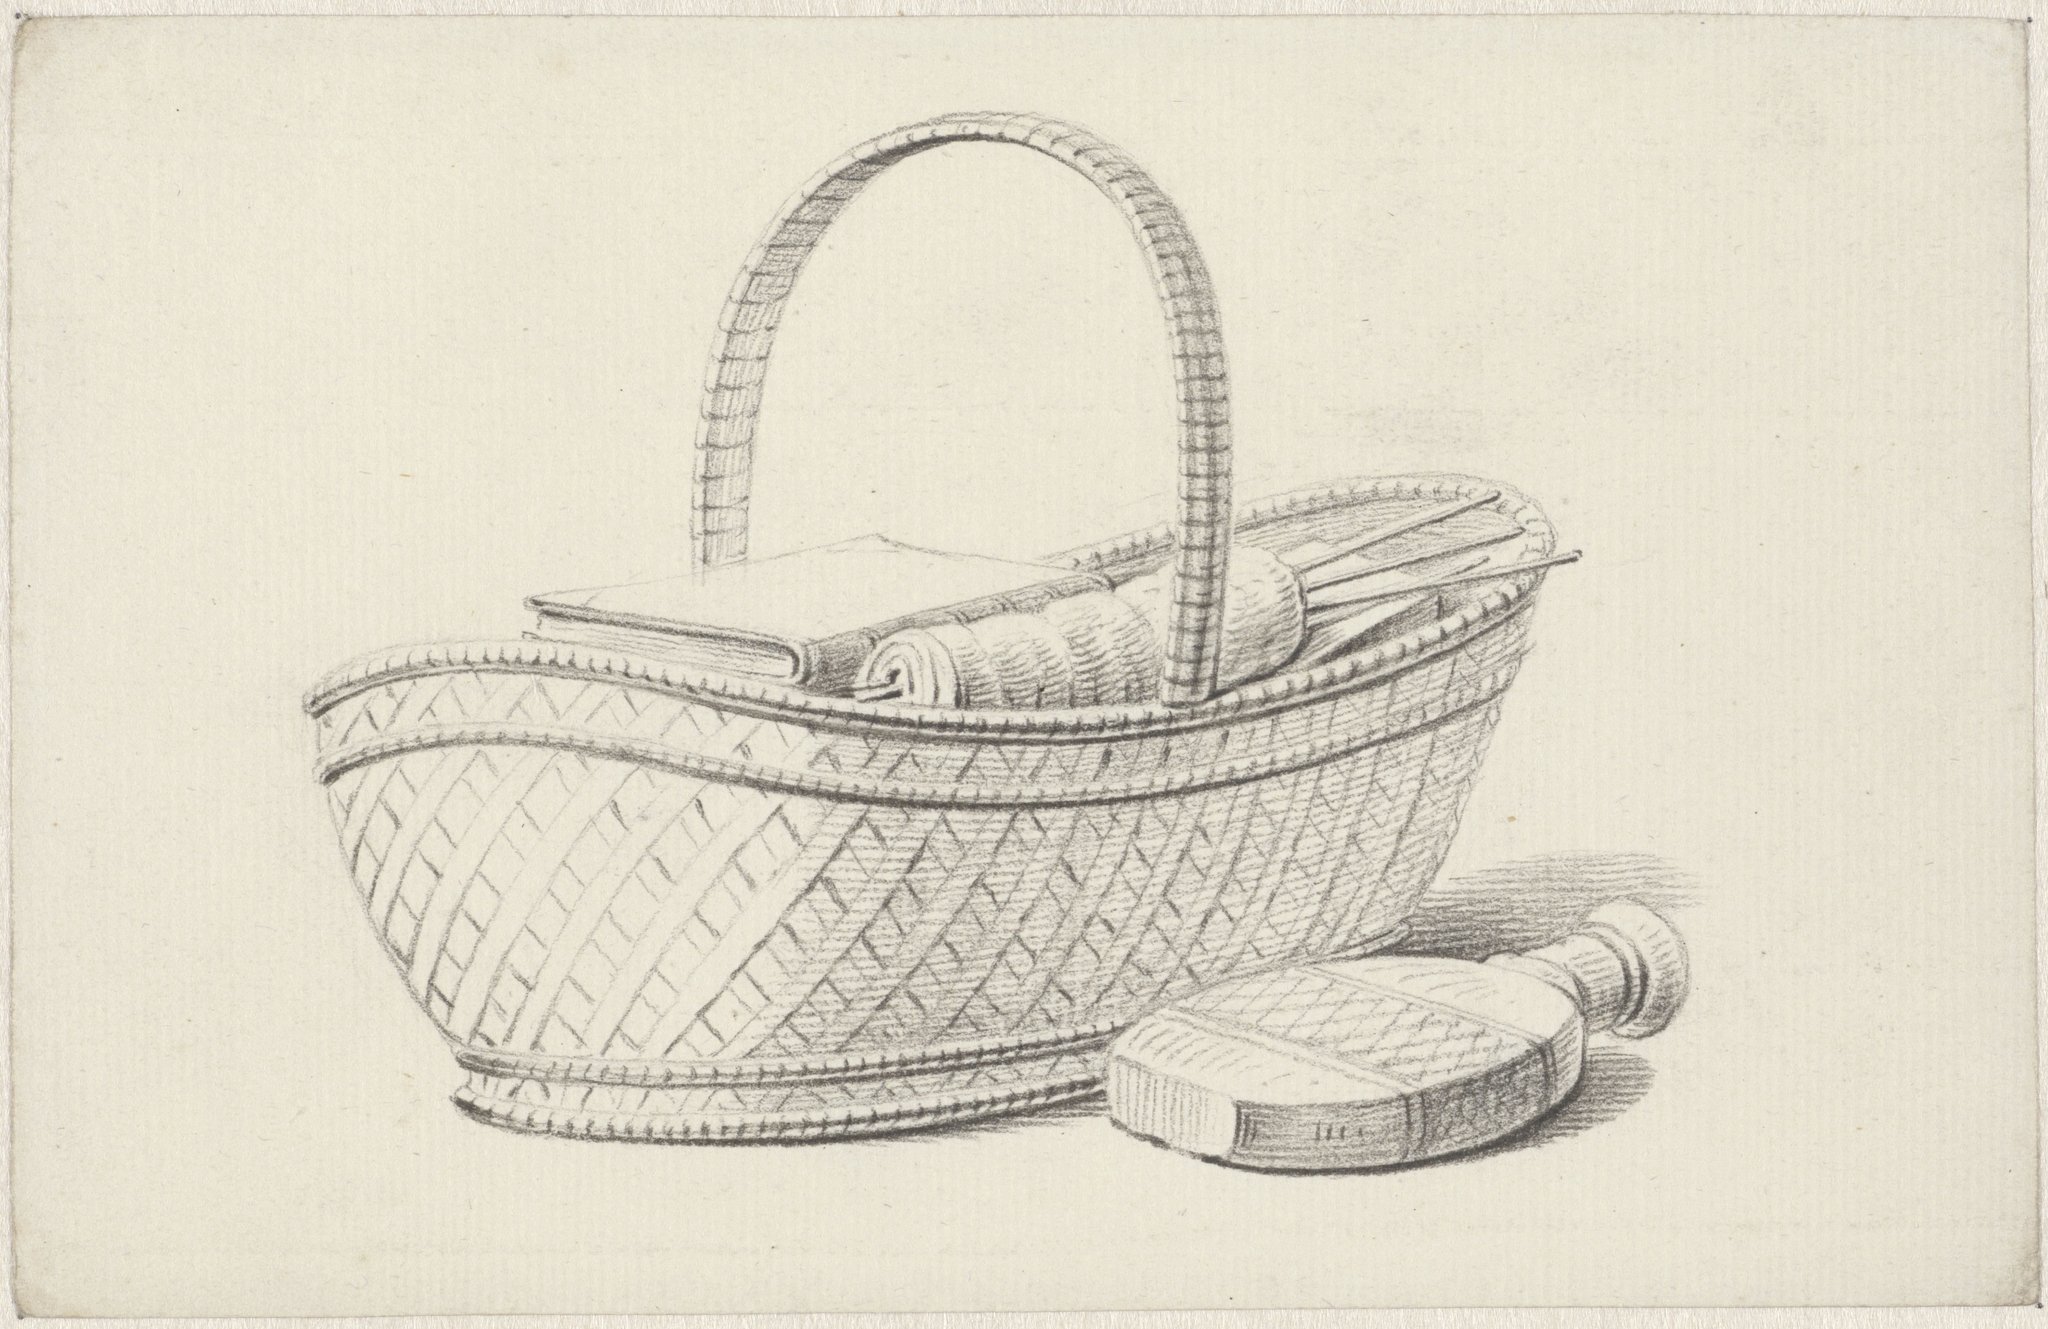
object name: drawing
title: Mand met boek en breiwerk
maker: pieter de goeje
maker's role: draughtsman, print maker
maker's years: 1789-1859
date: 1789-1859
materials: chalk, paper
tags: container made of plant material other than wood: basket, still life of related objects, (other forms of) needlework, e.g.: crocheting, knitting, embroidering